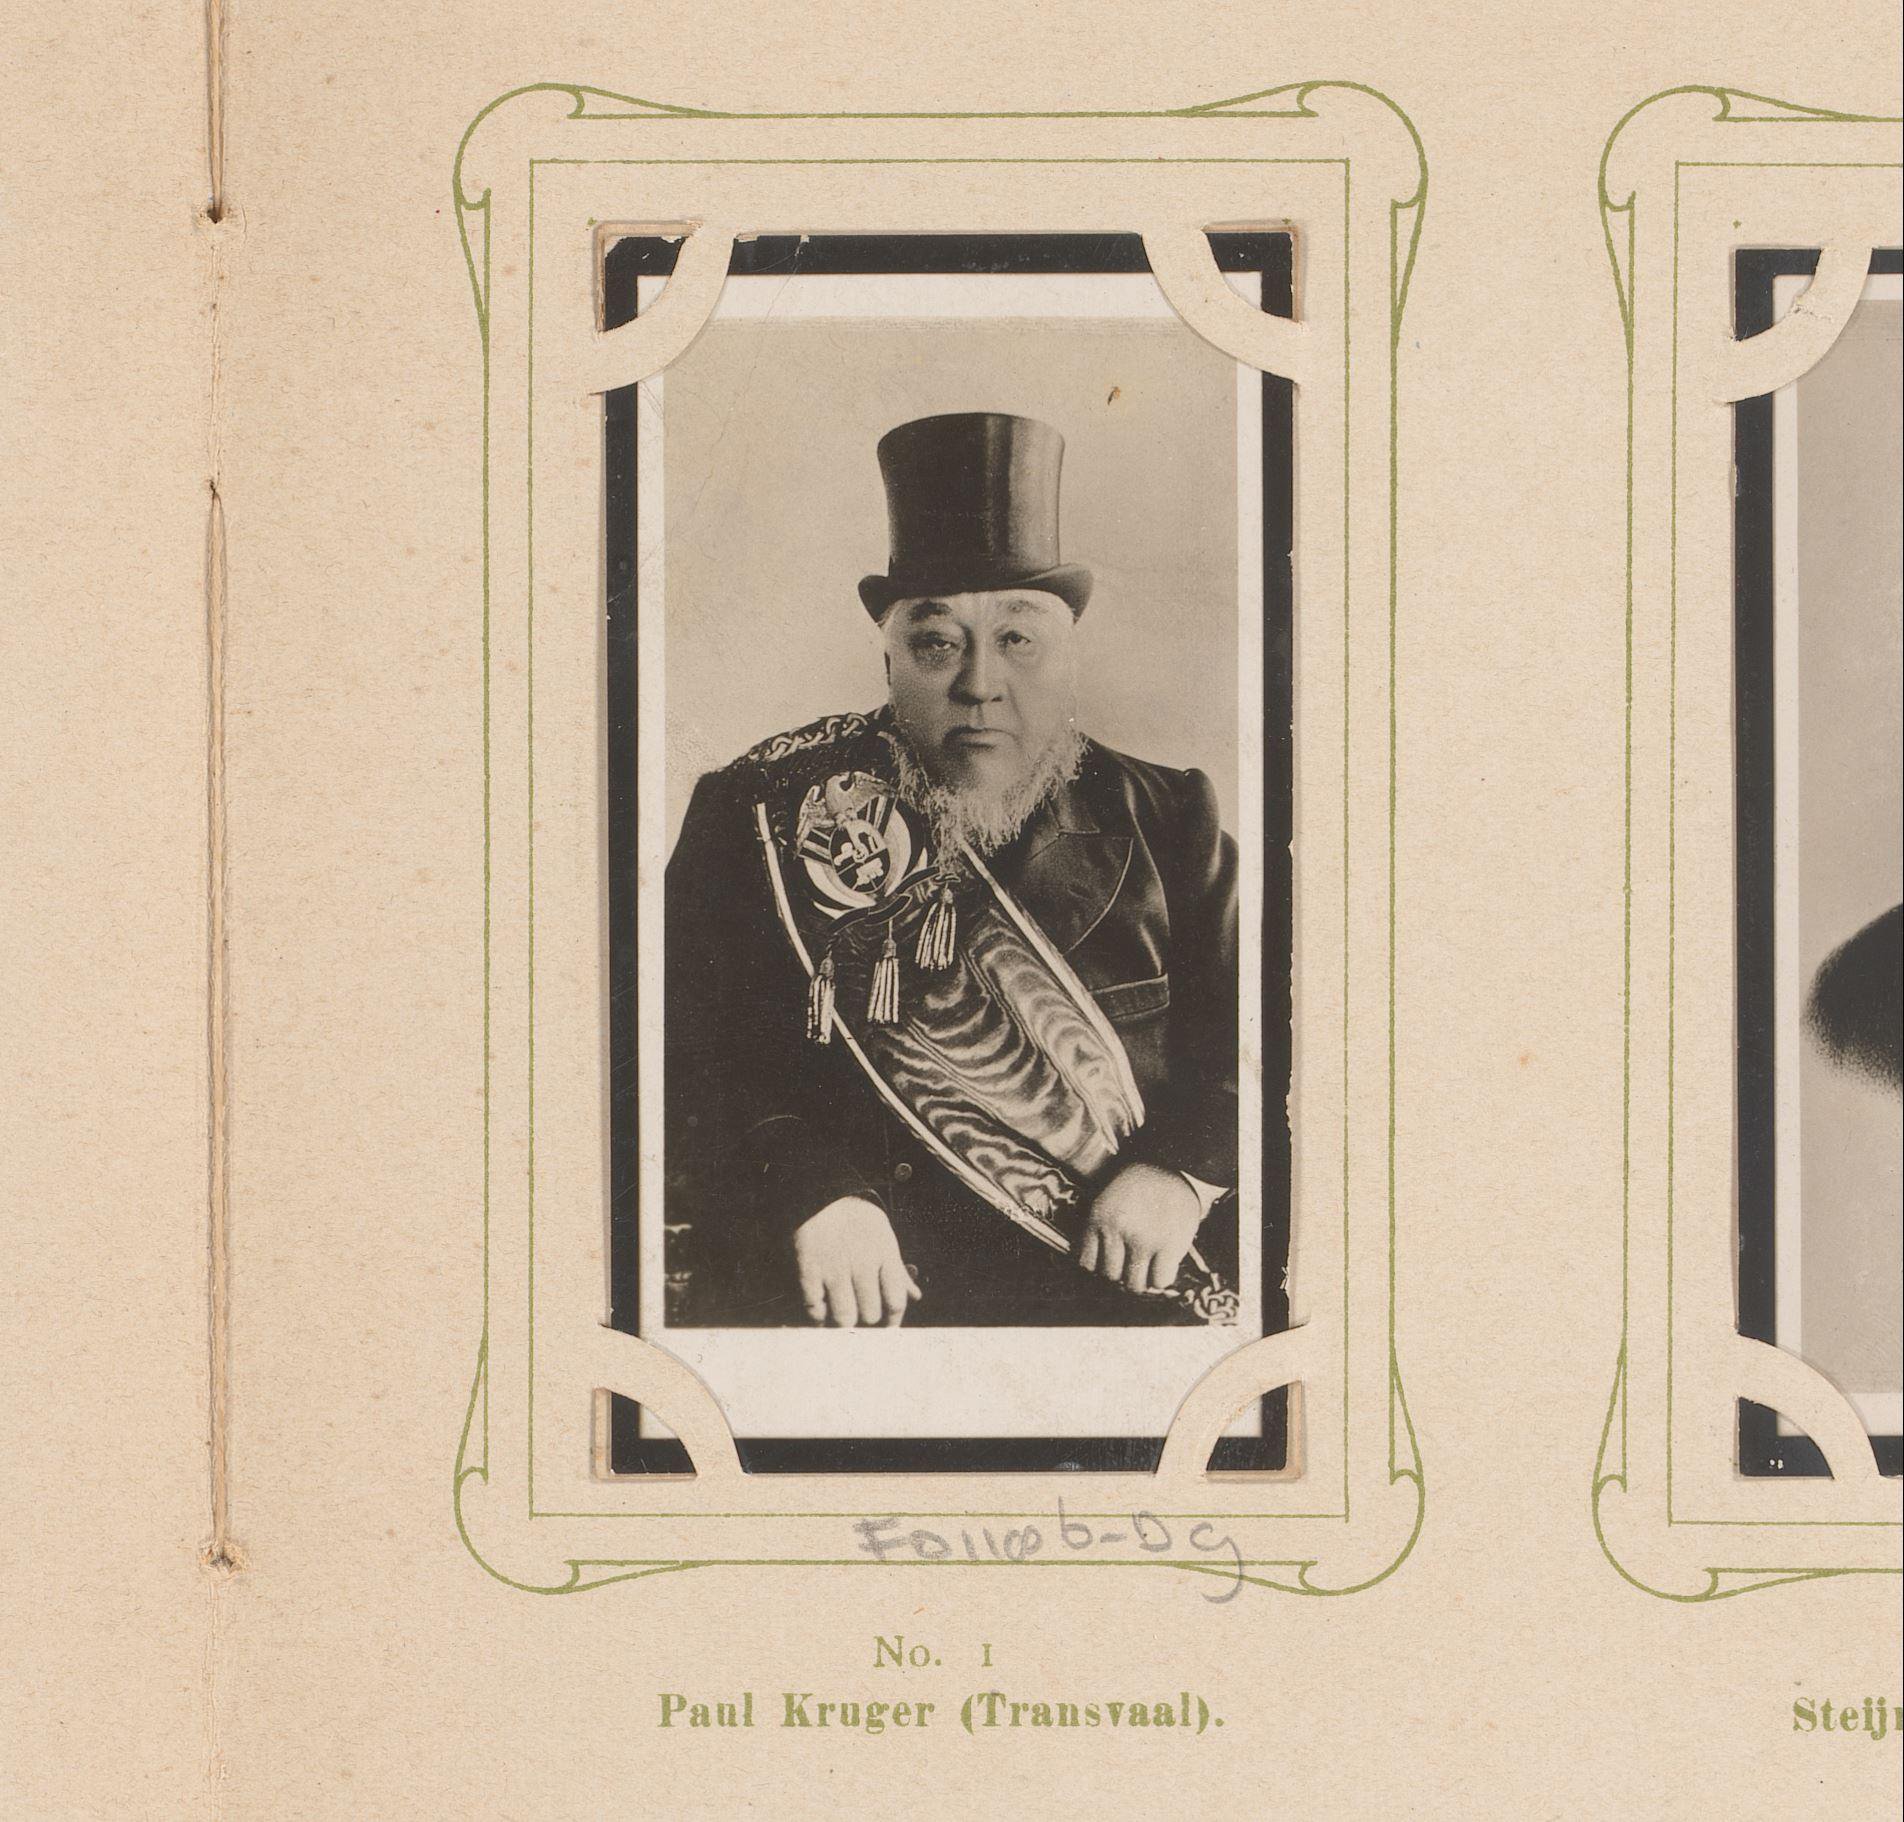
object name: photograph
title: Portret van Paul Kruger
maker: Anonymous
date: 1904-1905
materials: photographic support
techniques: gelatin silver print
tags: official; civil servant; functionary (in general), historical persons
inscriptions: inscription: ‘No. 1./ Paul Kruger (Transvaal).’